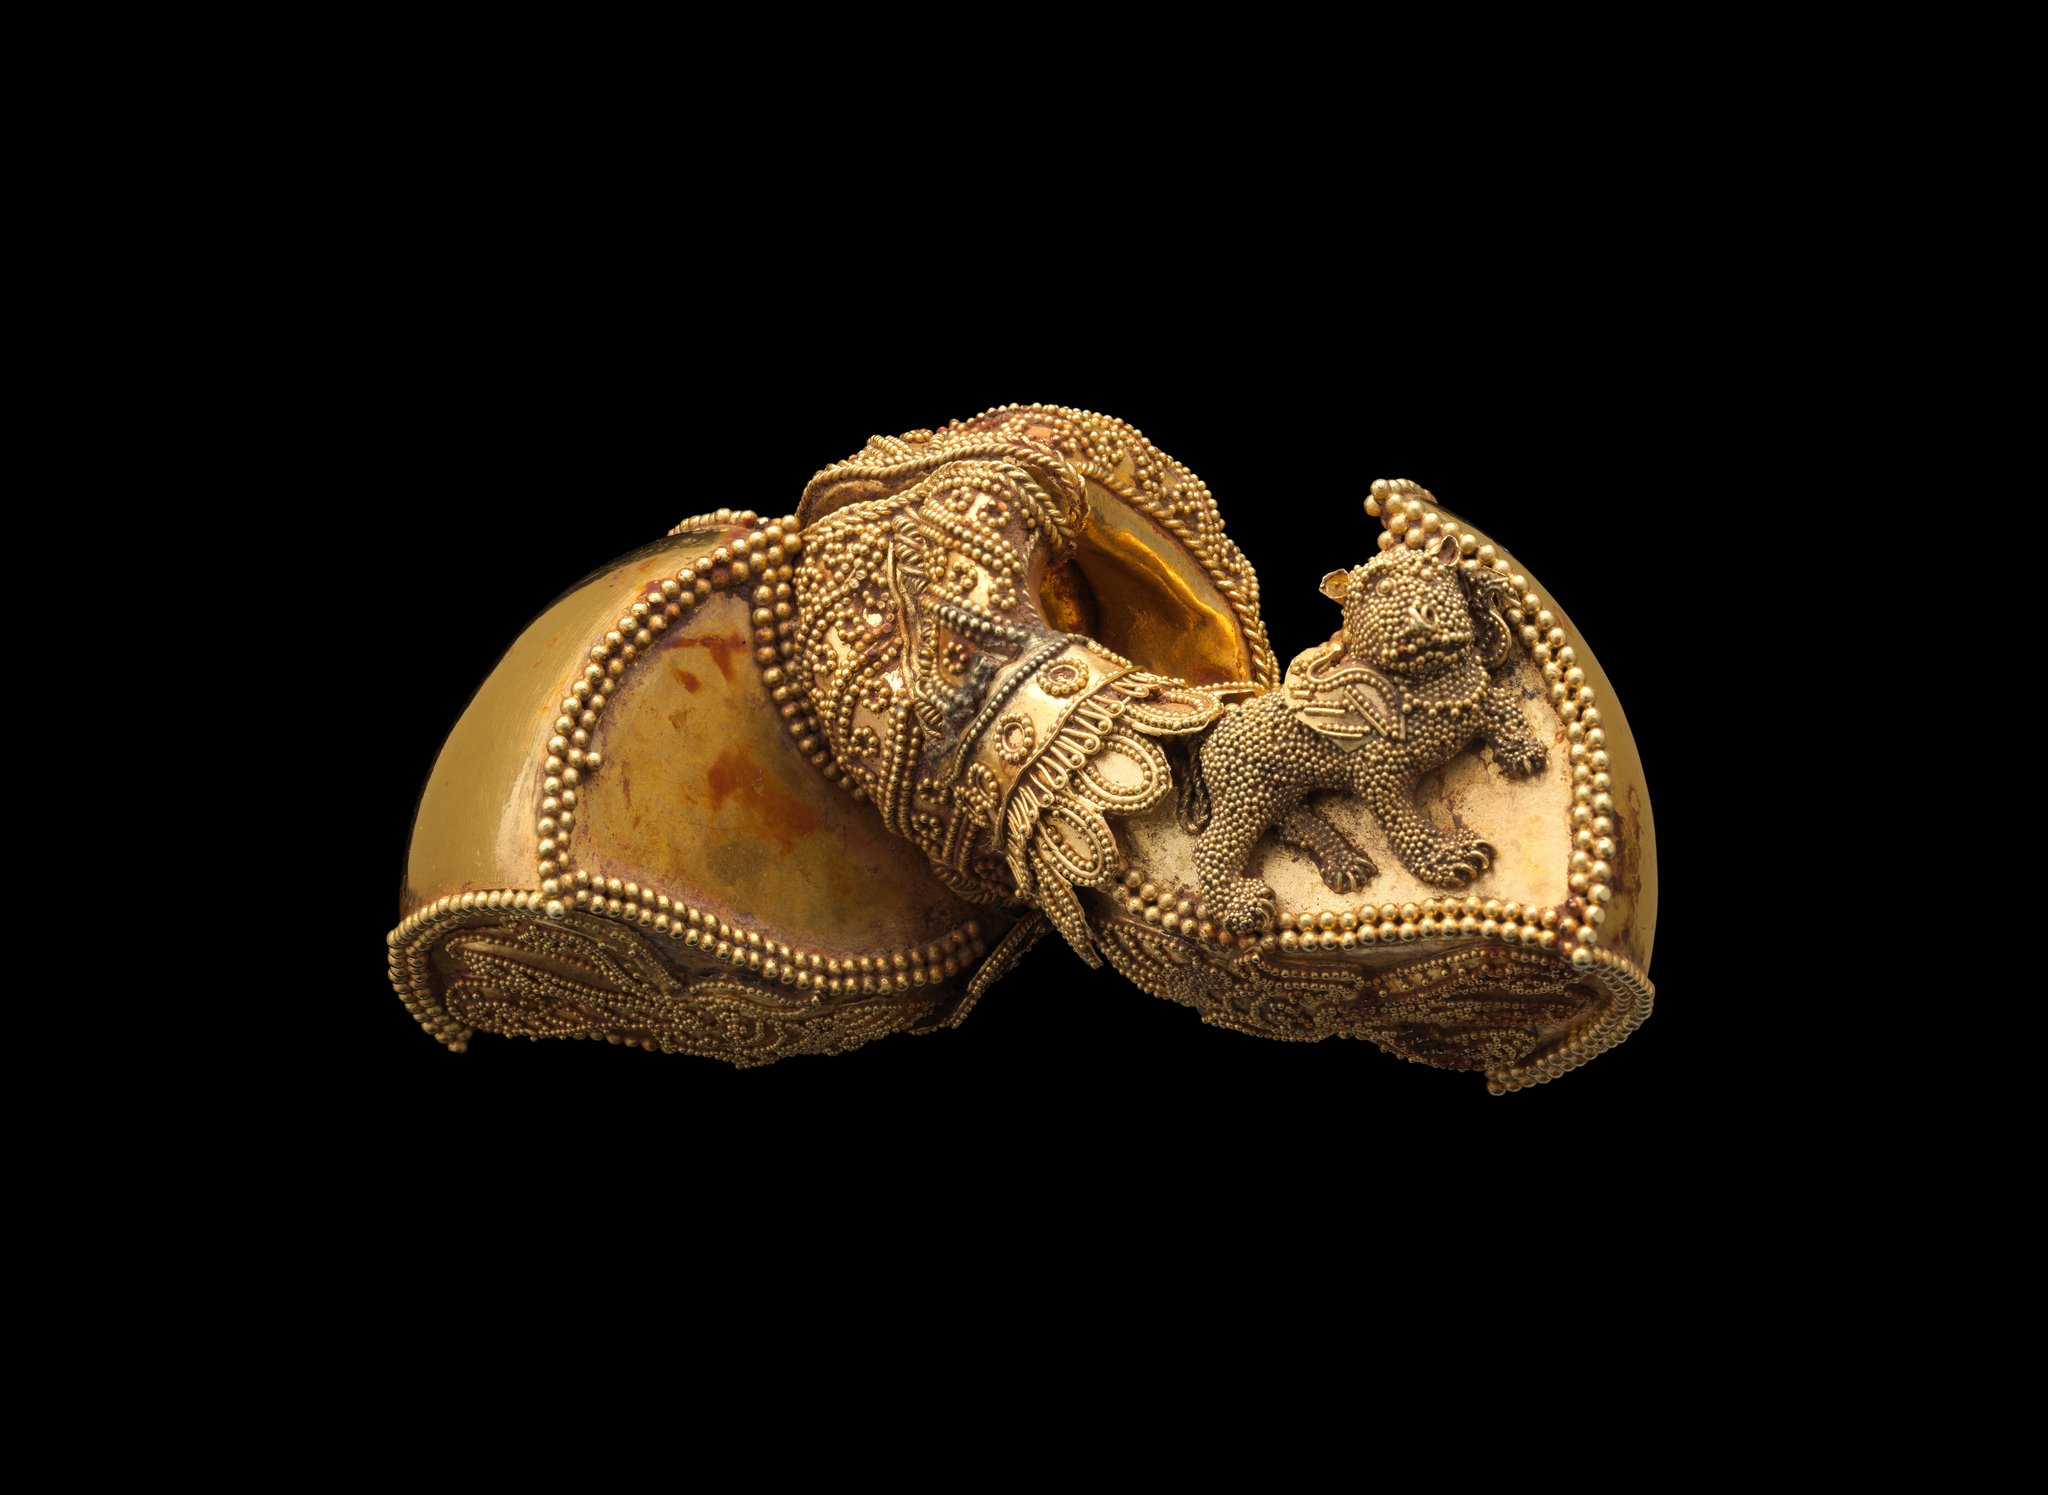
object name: earring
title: One from a Pair of Ear Ornaments (Prakaravapra Kundala)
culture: indian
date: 1-100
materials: gold, metal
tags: satavahana,elephants,lions